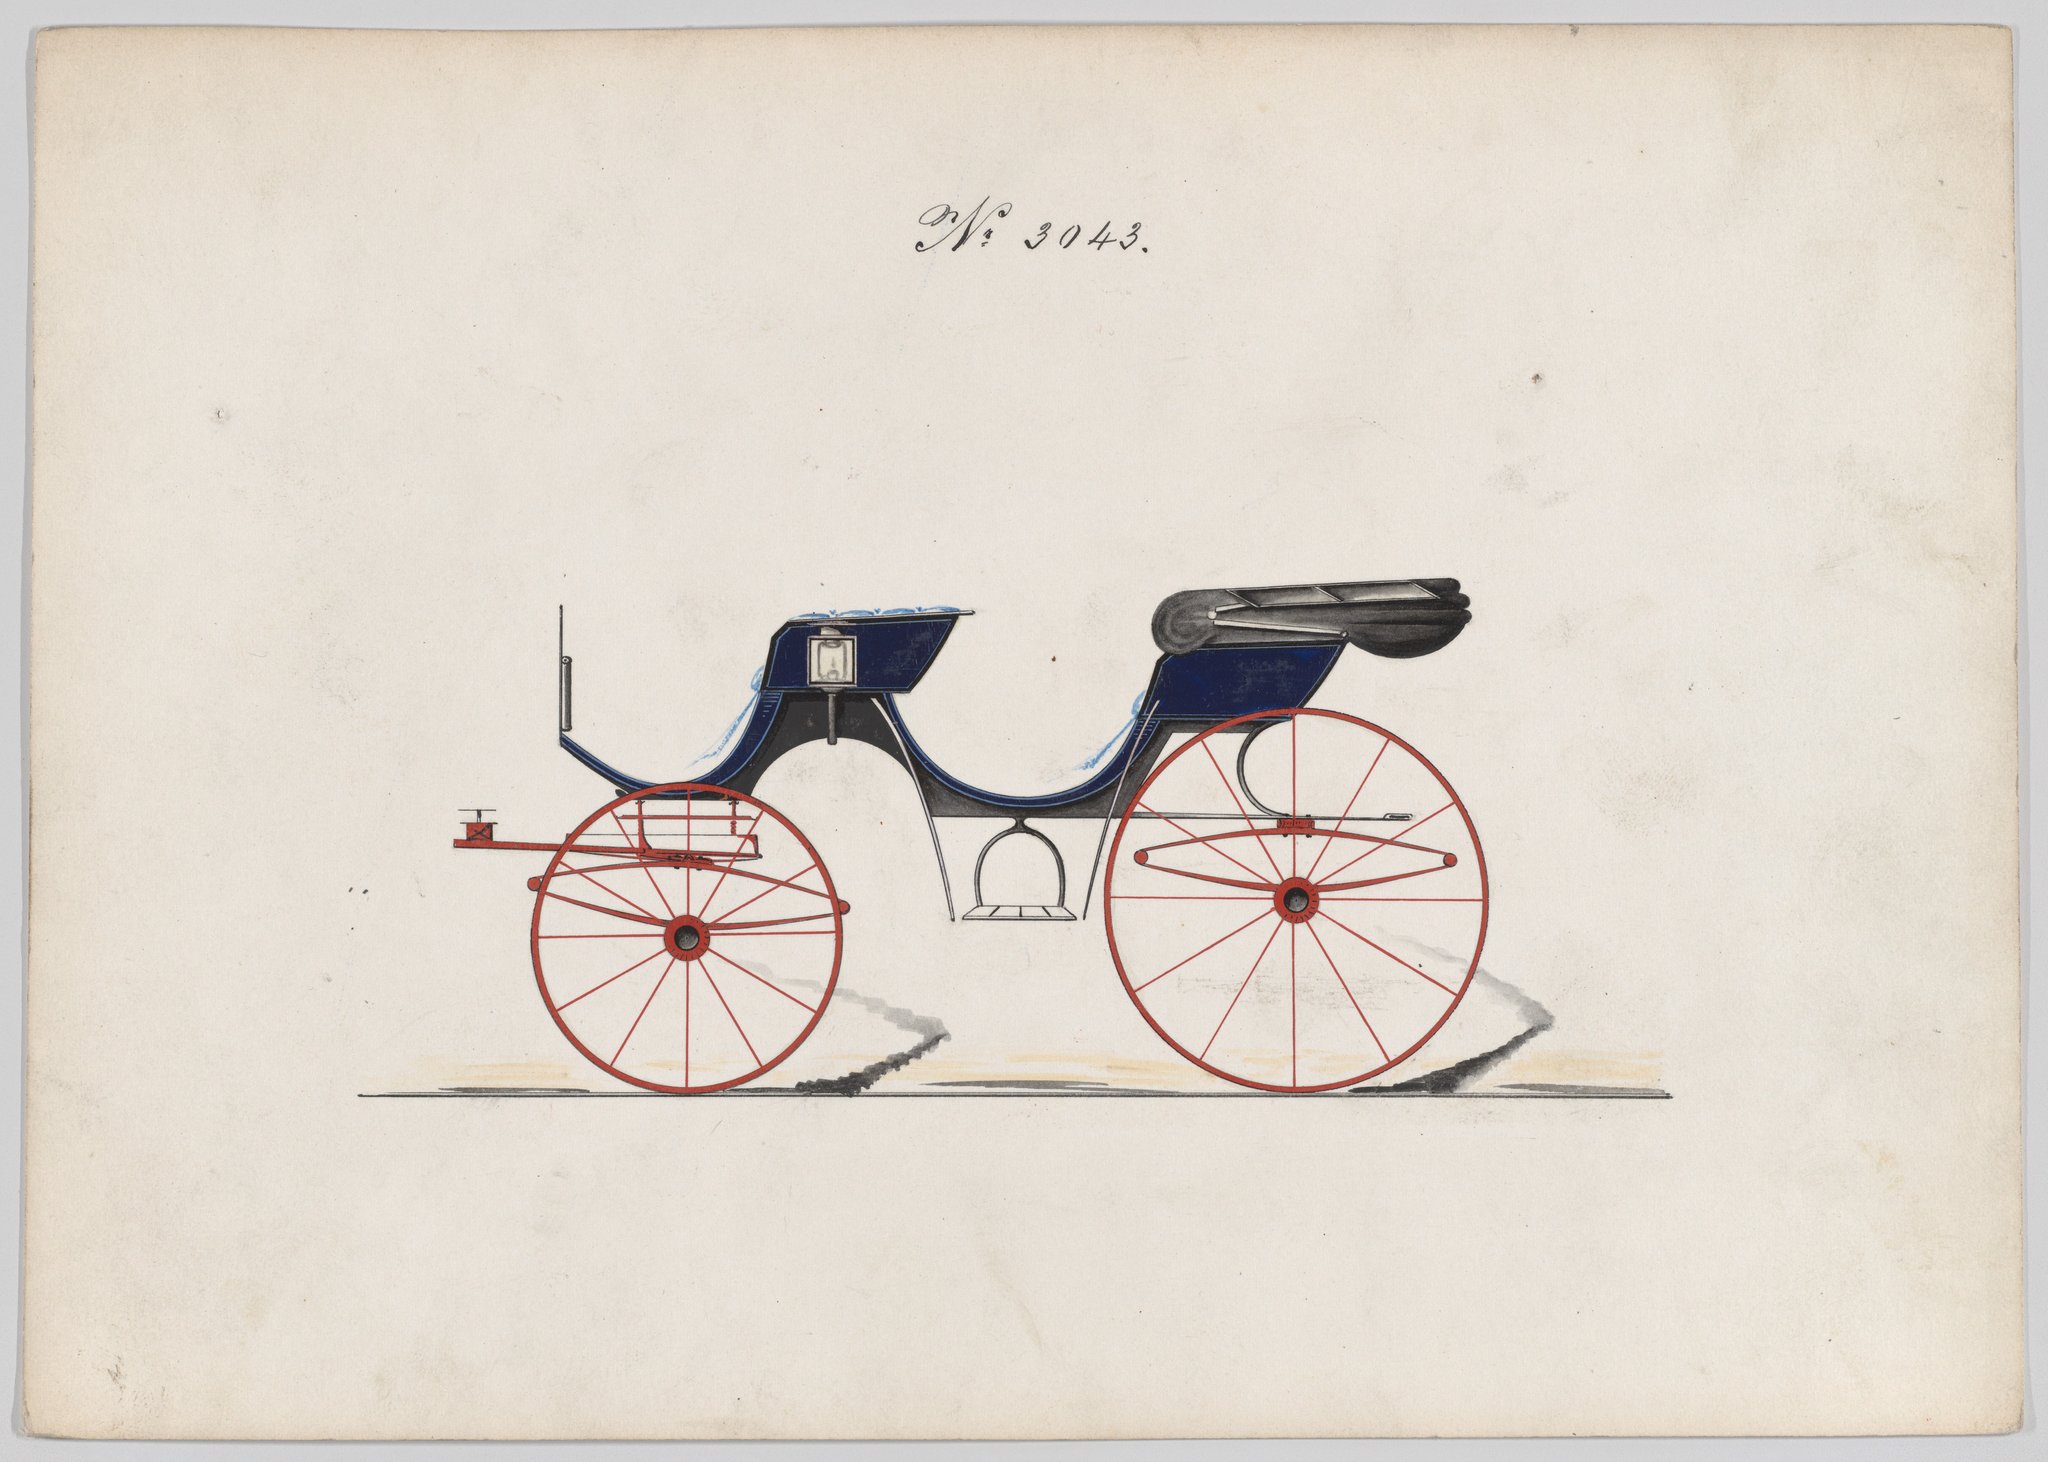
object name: drawing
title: Design for 2 seat Phaeton, no. 3043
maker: brewster & co.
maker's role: manufacturer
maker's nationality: american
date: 1874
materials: gouache, gum arabic, ink, watercolor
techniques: pen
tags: carriages